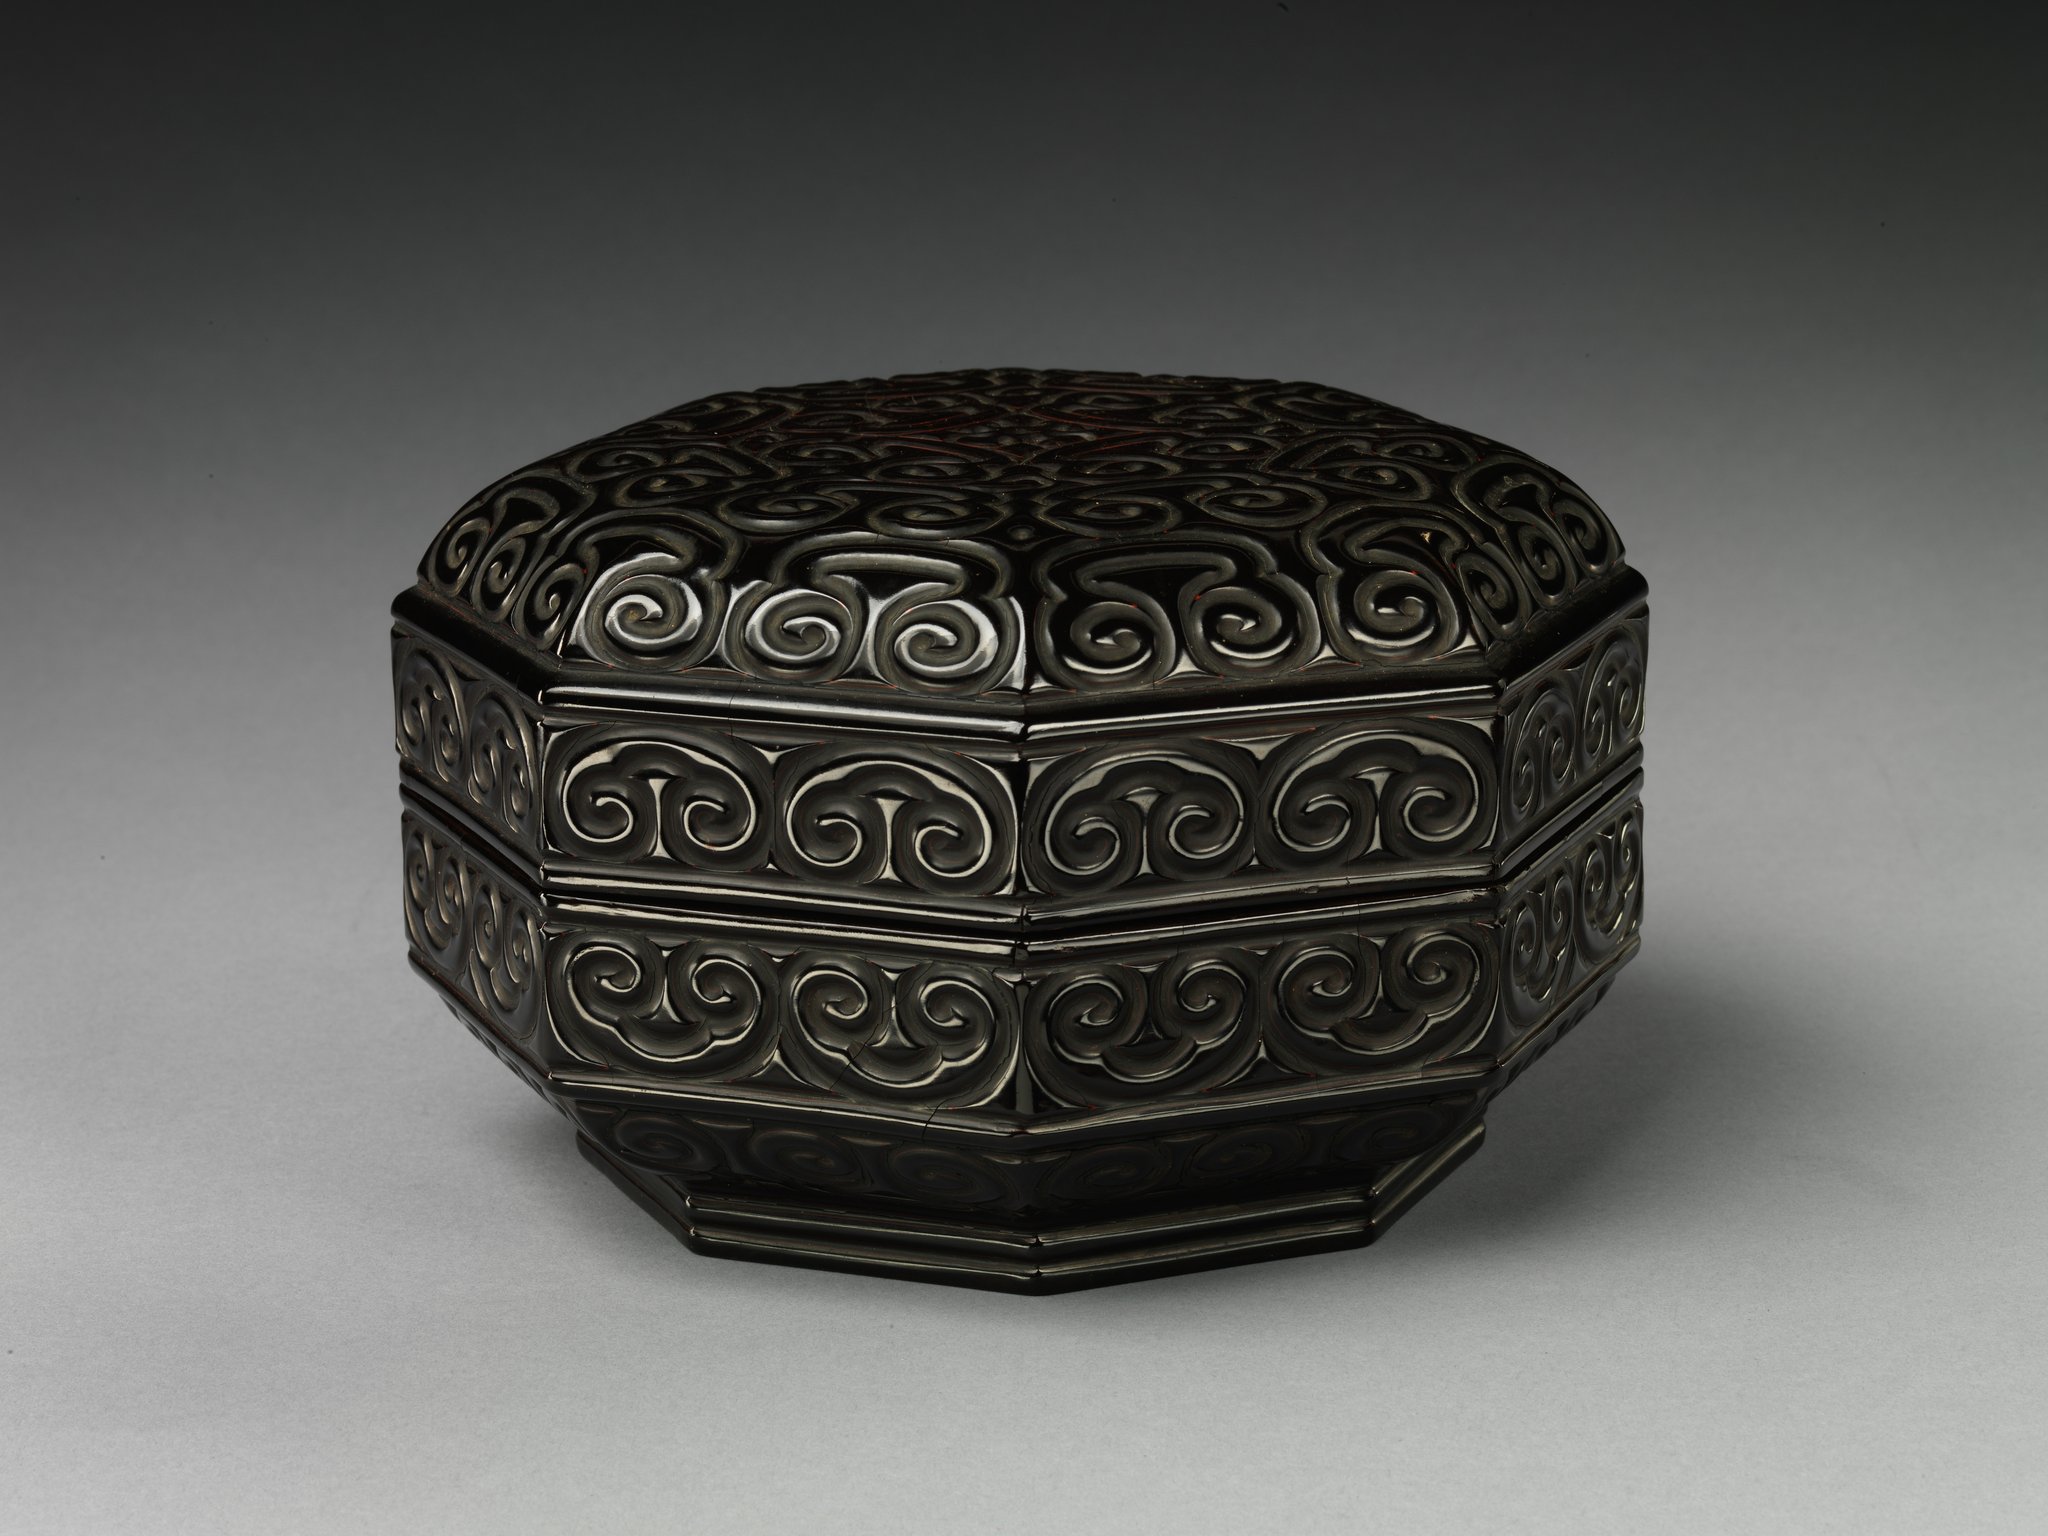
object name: box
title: Octagonal box with pommel scrolls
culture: chinese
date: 1367-1433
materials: lacquer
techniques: carving